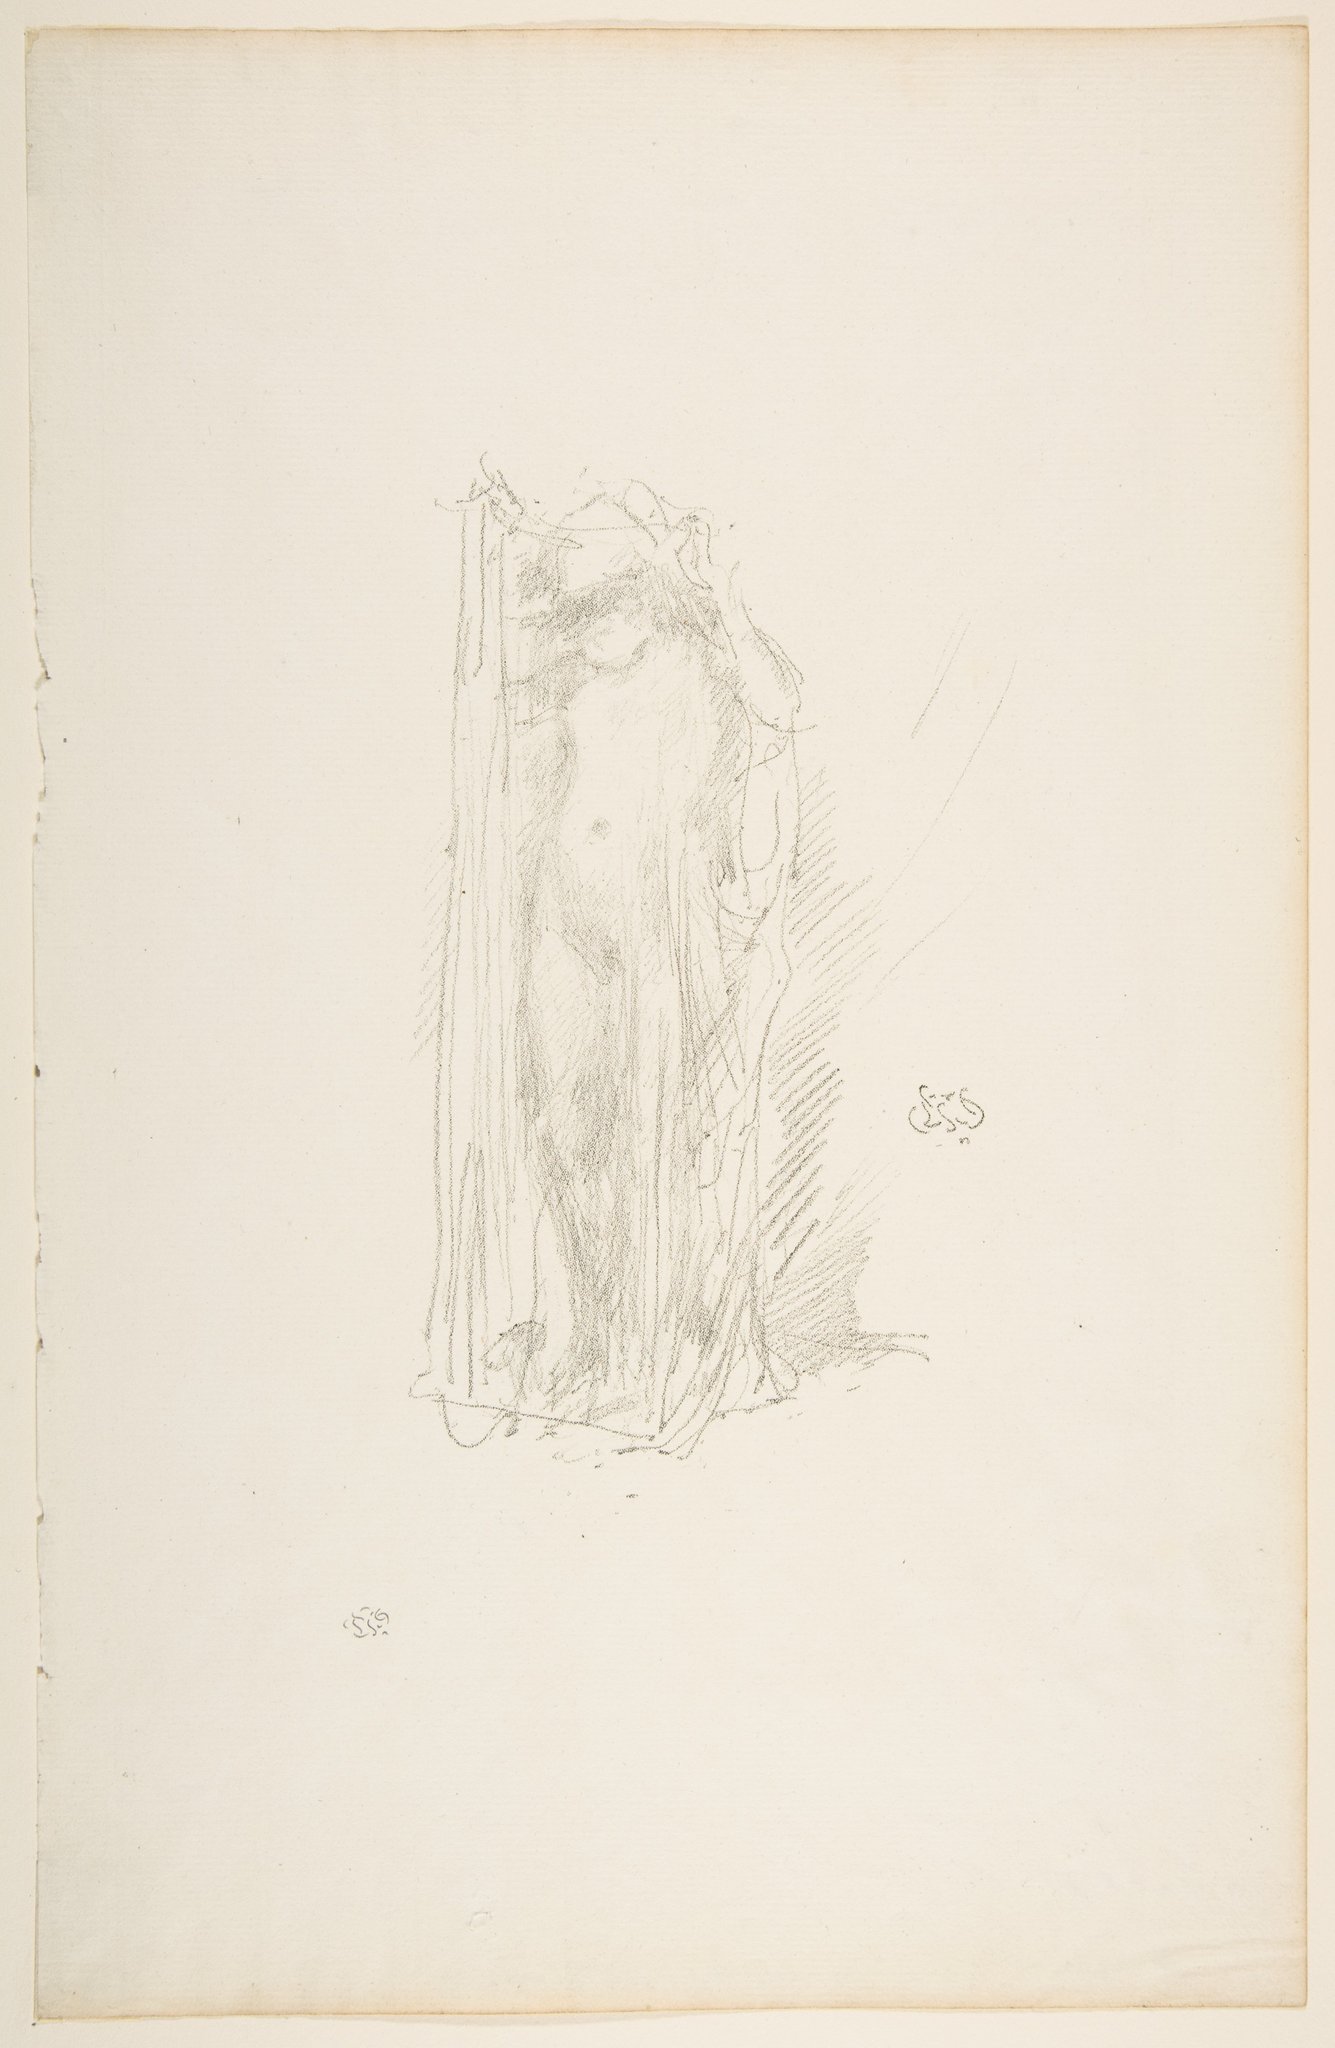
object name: print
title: Model Draping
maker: james mcneill whistler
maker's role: artist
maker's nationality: american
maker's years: 1834-1903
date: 1889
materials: graphite, ink, paper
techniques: printing, lithography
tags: male nudes